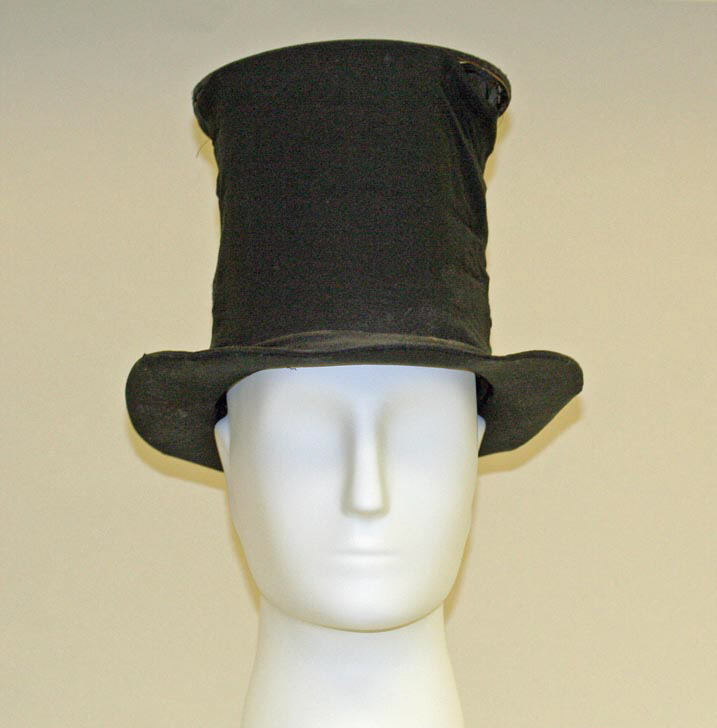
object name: opera hat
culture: british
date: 1848-1849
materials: metal, silk